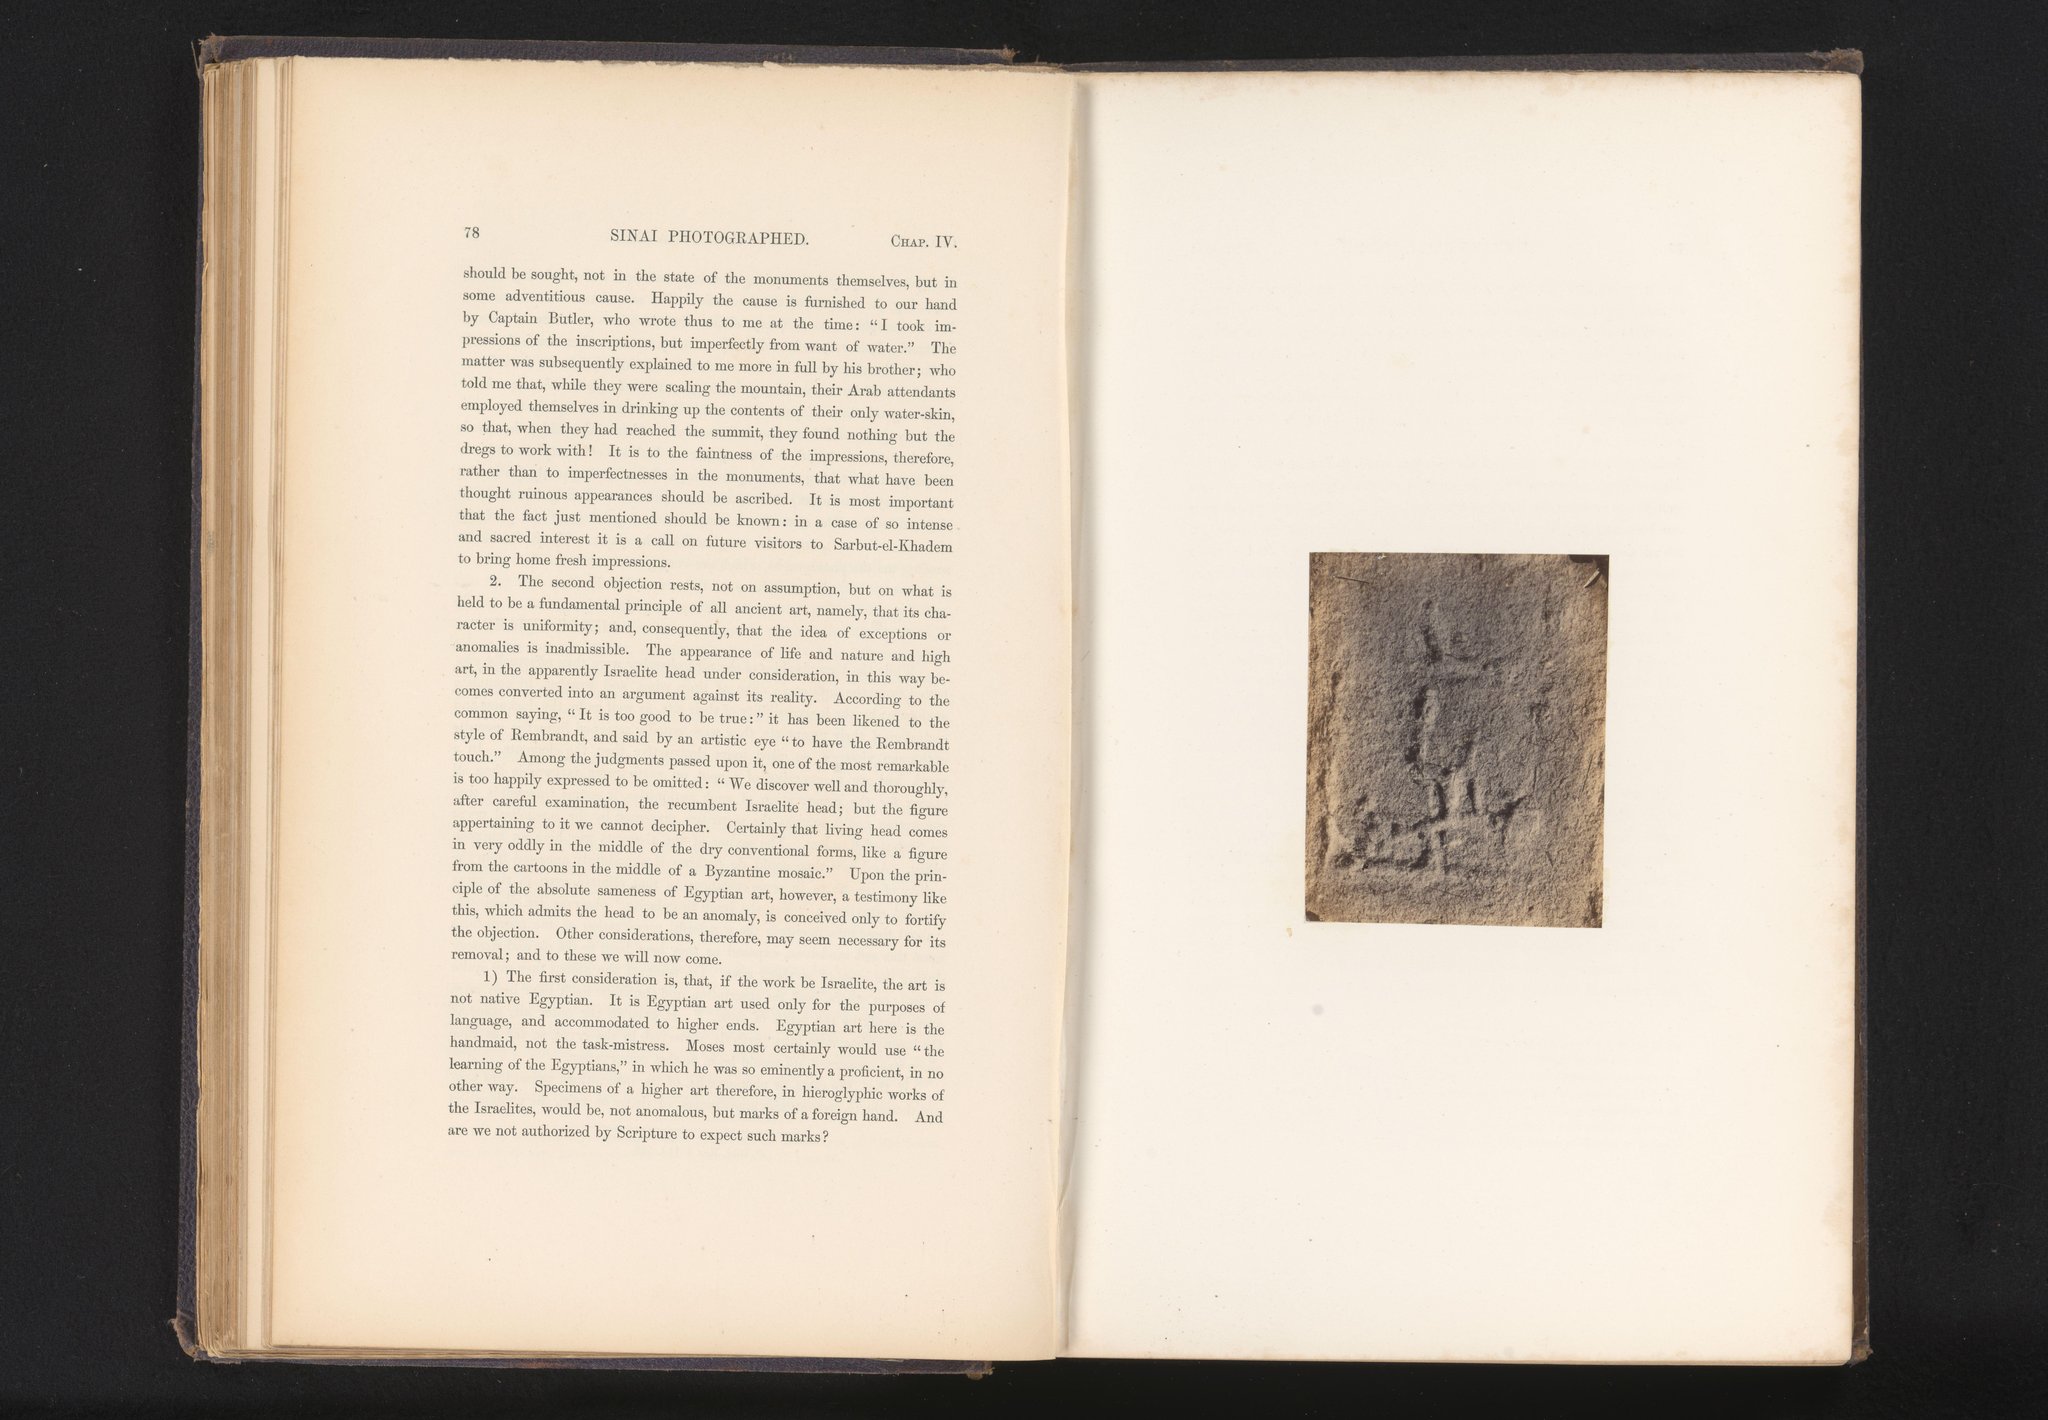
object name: photograph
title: Portion of Tablet containing Israelite's Head, real size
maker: a.j. brown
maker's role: fotograaf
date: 1857-1862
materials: paper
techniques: albumen print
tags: egyptian hieroglyphs